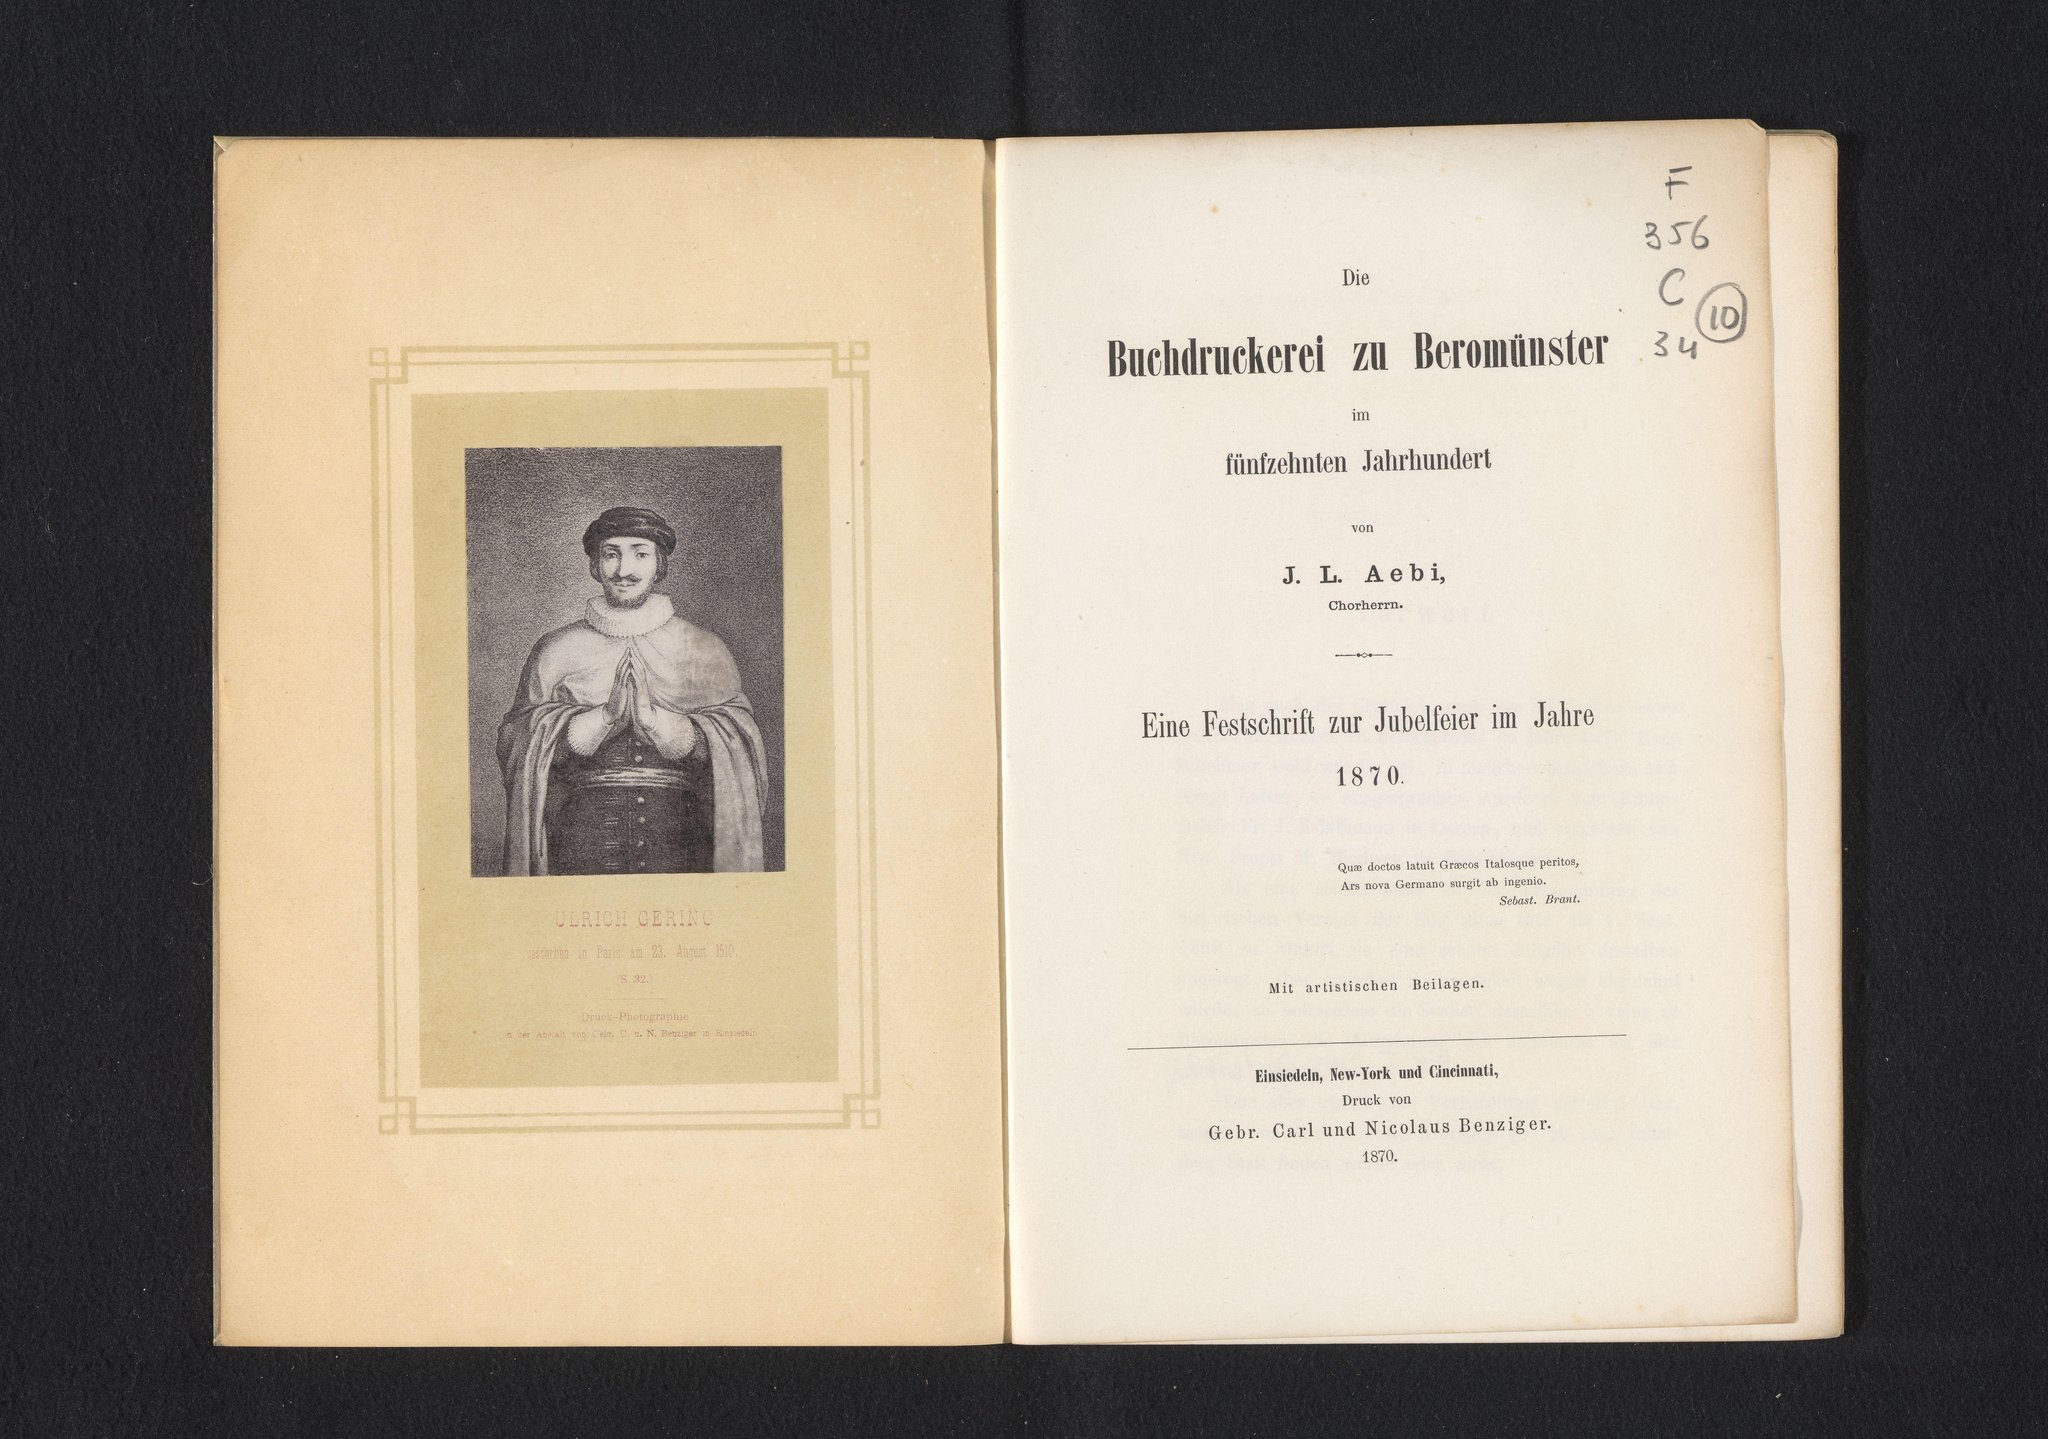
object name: book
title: Die Buchdruckerei zu Beromüntser im fünfzehnten Jahrhundert : eine Festschrift zur Jubelfeier im Jahre 1870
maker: j.l. aebi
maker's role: schrijver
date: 1871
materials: paper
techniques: photograph, printing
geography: einsiedeln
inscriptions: bookplate: ‘SFJ ex libris’, inscription: ‘MAY 1981’